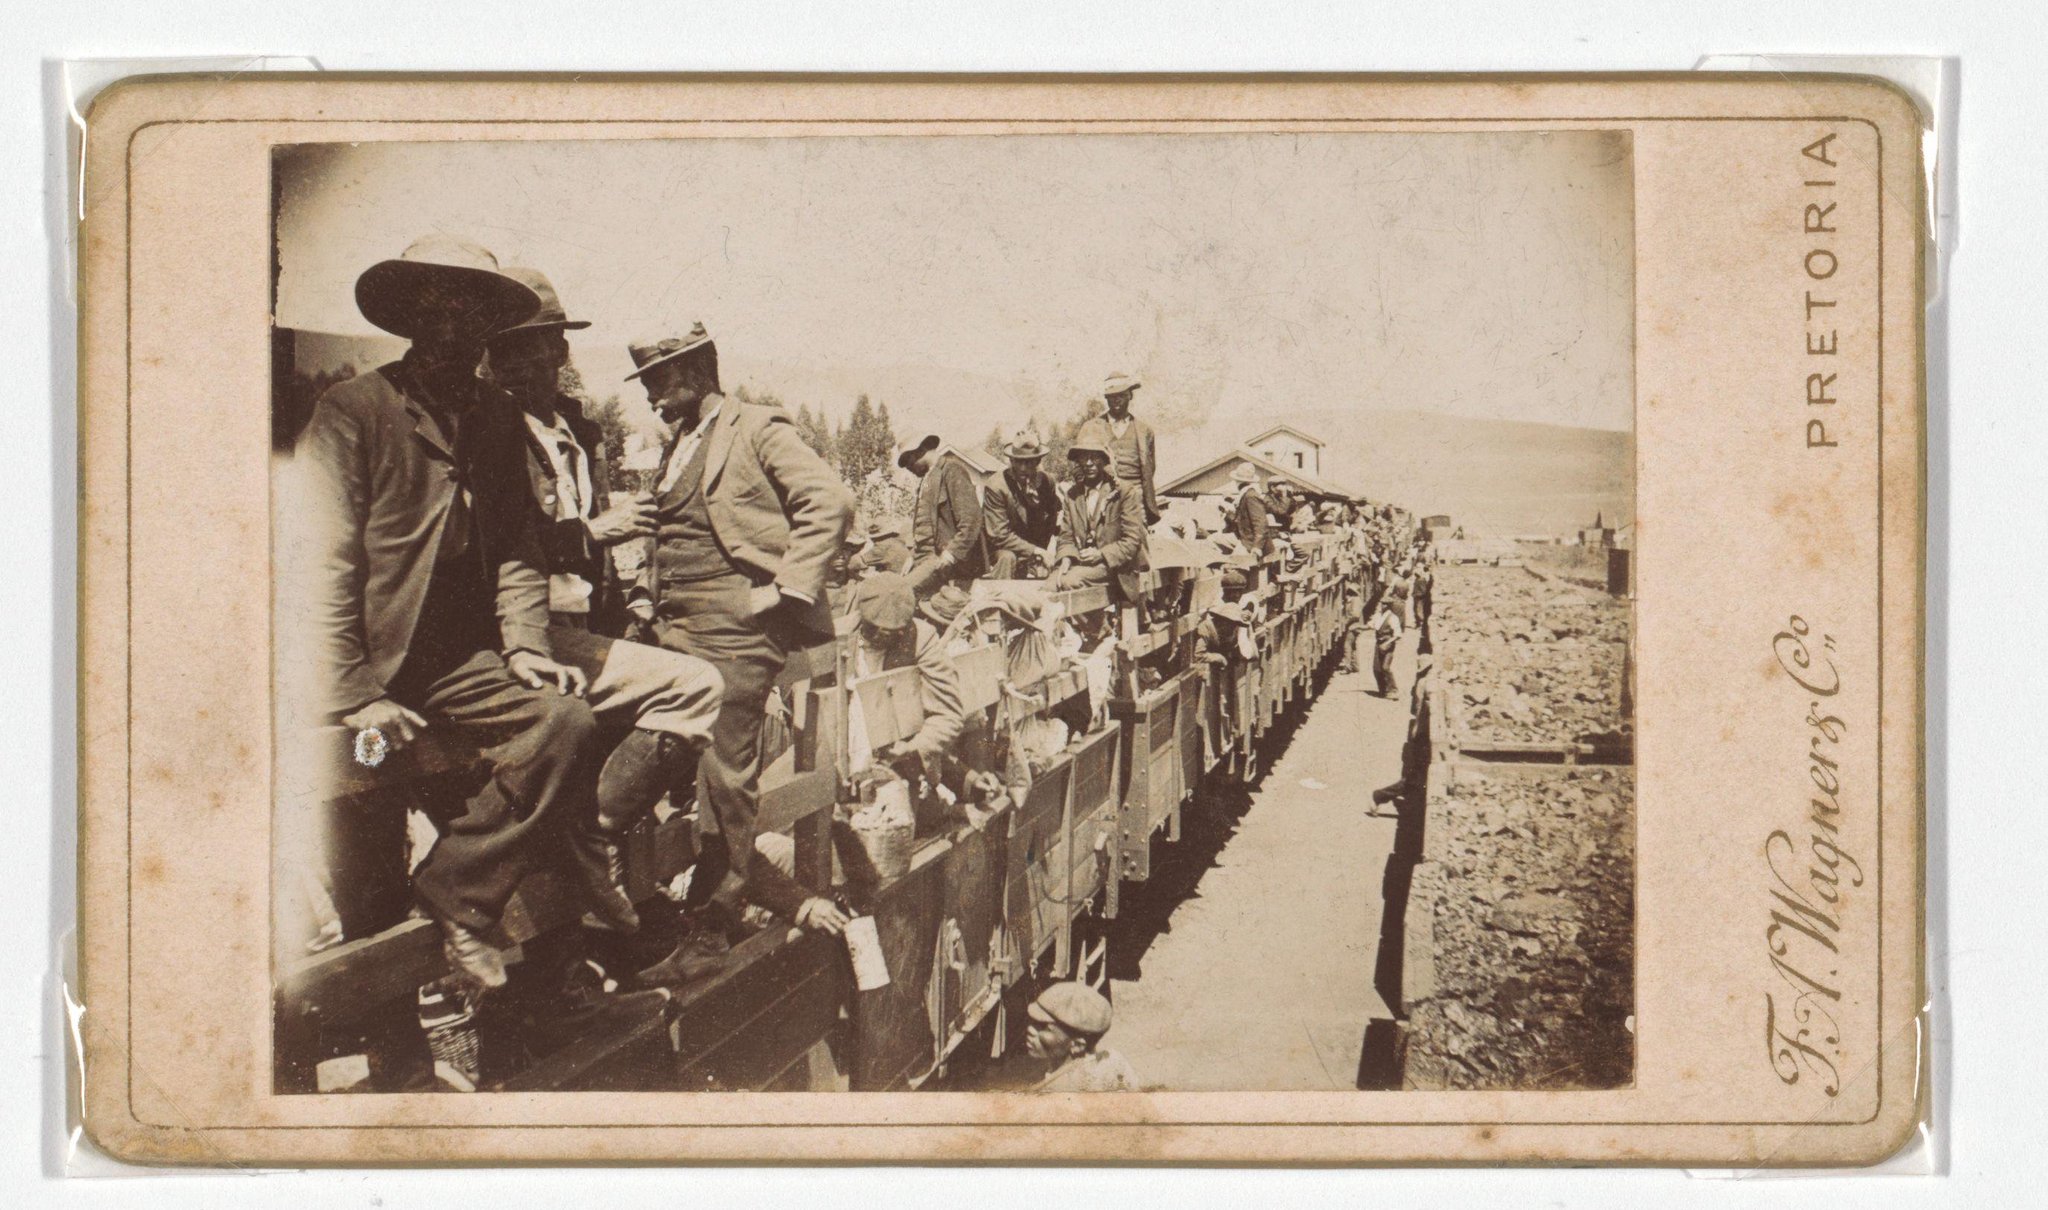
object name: photograph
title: Trein met vluchtende Zuid-Afrikanen kort voor het uitbreken van de Tweede Boerenoorlog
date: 1899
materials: cardboard, paper, photographic support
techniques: daylight paper print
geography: pretoria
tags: historical persons, station; shelter (railway, tramway)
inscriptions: inscription: ‘Vluchtende Sjangaansche Kaffers. Extra trein 8/10-99 smorgens 5 uur.’